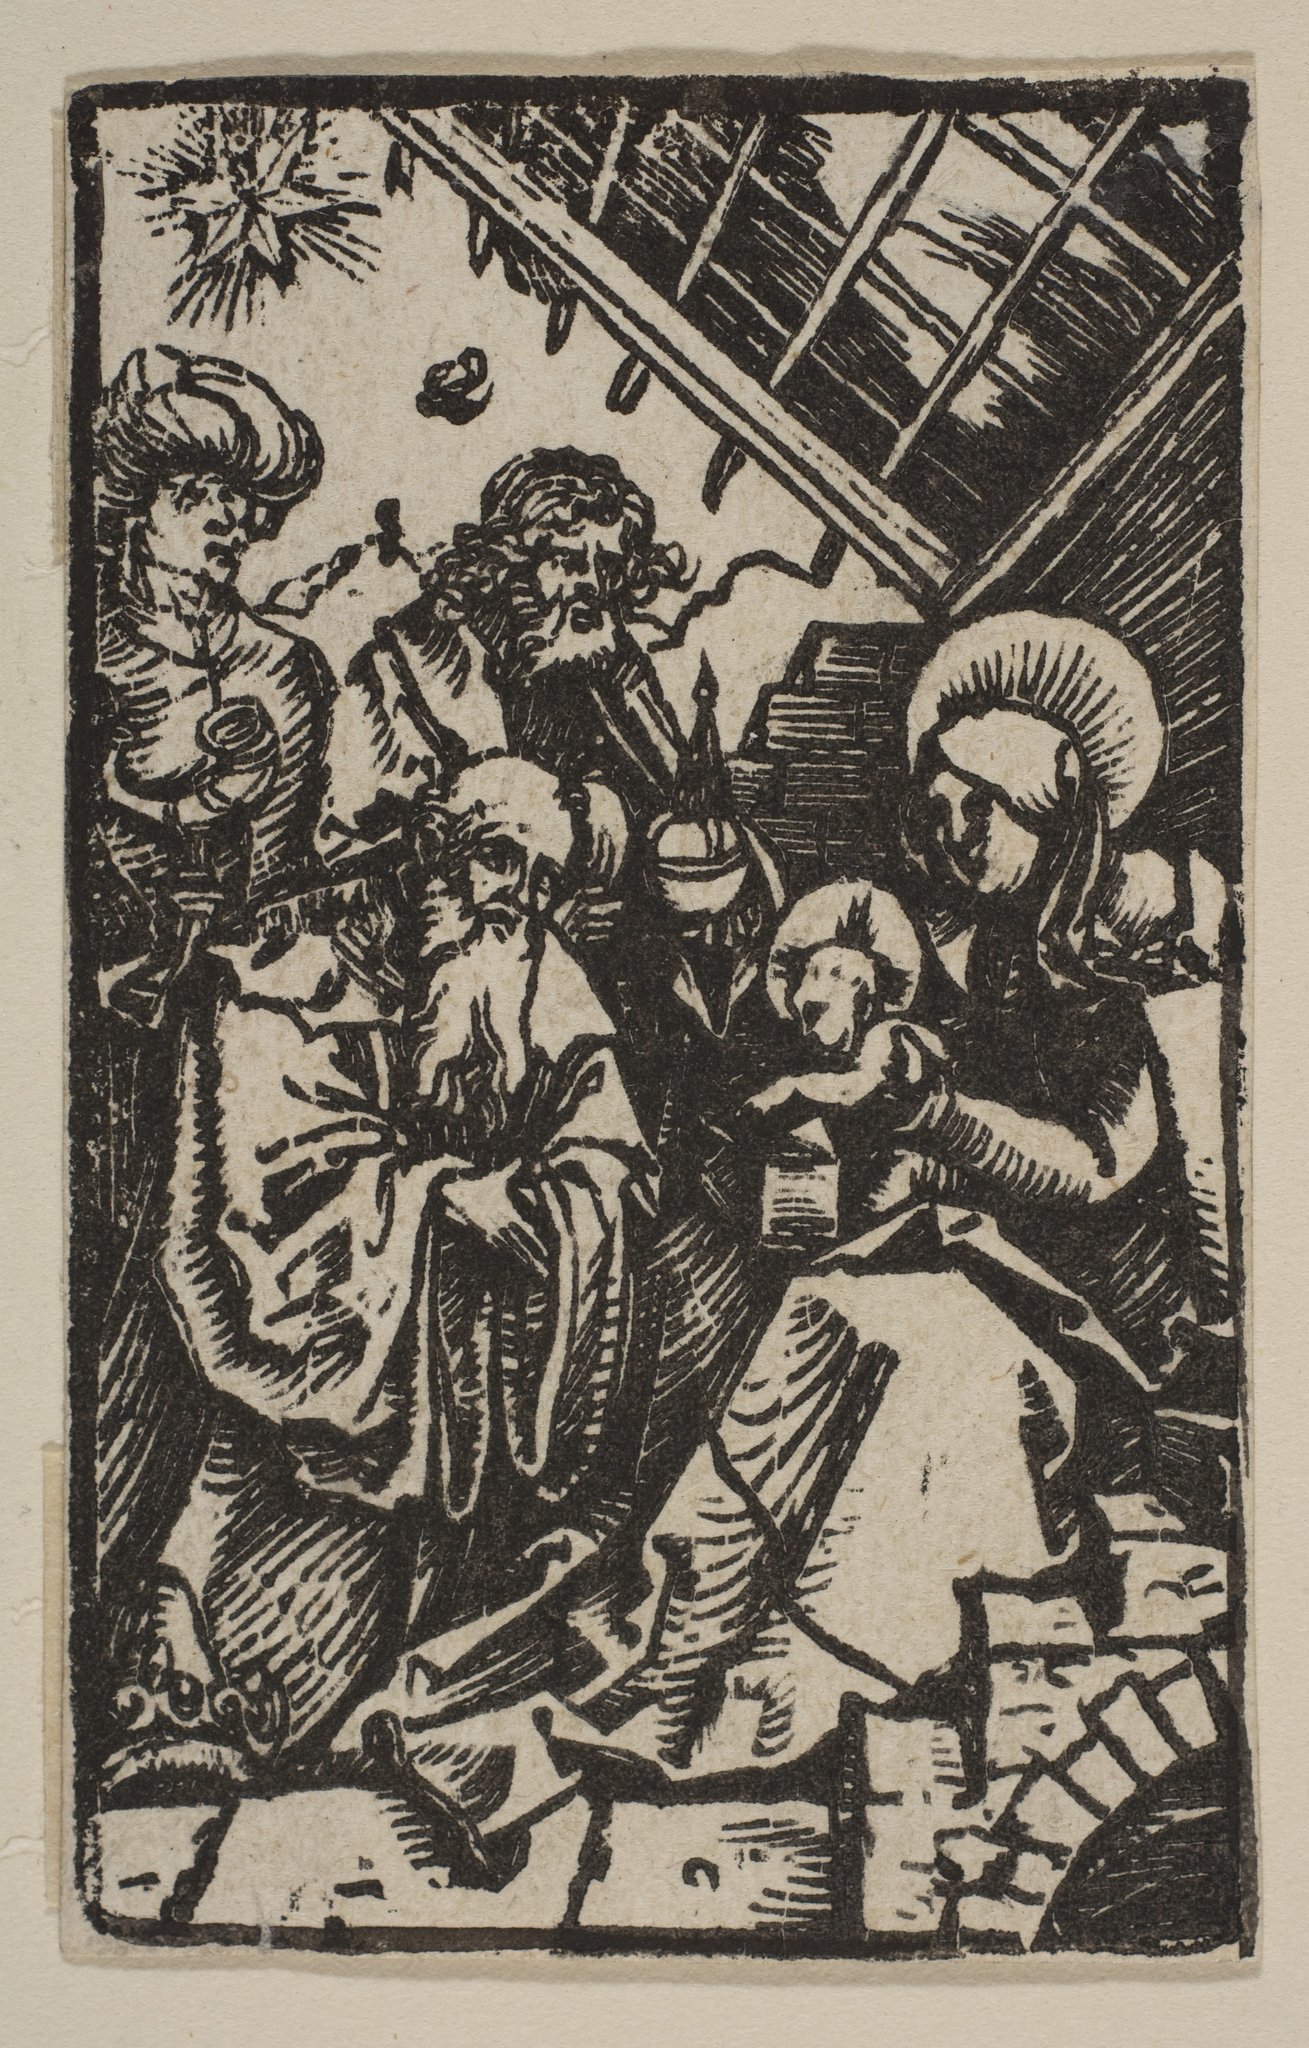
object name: print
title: The Adoration of the Kings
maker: albrecht dürer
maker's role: artist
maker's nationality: german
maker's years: 1471-1528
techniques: woodcut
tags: adoration of the magi